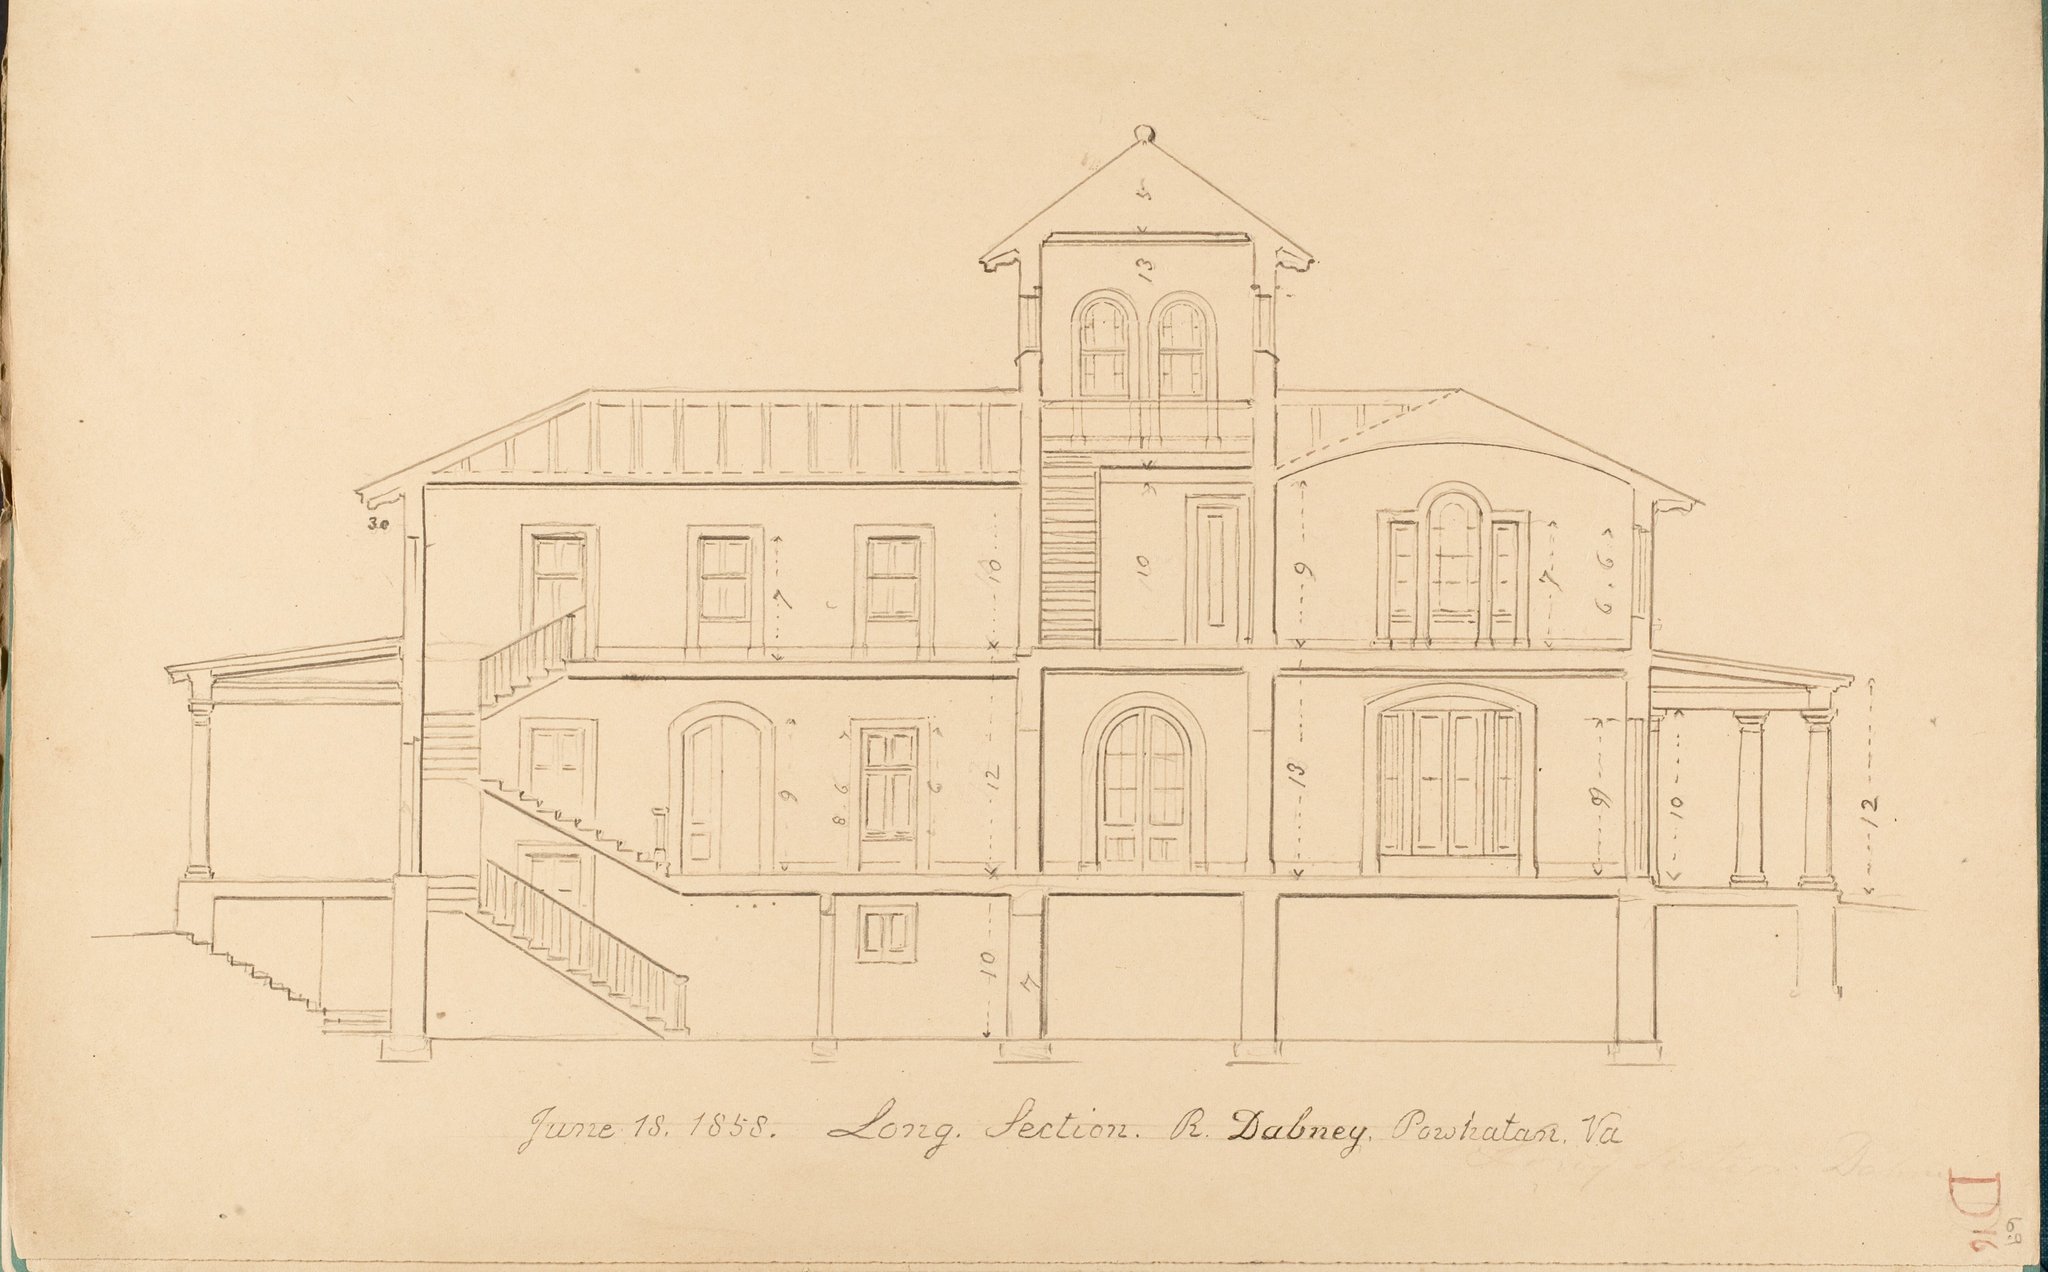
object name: drawing ornament architecture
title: House of R. Dabney, Powhatan, Virginia (long section)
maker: alexander jackson davis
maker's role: artist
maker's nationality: american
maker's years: 1803-1892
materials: ink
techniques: wash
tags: houses